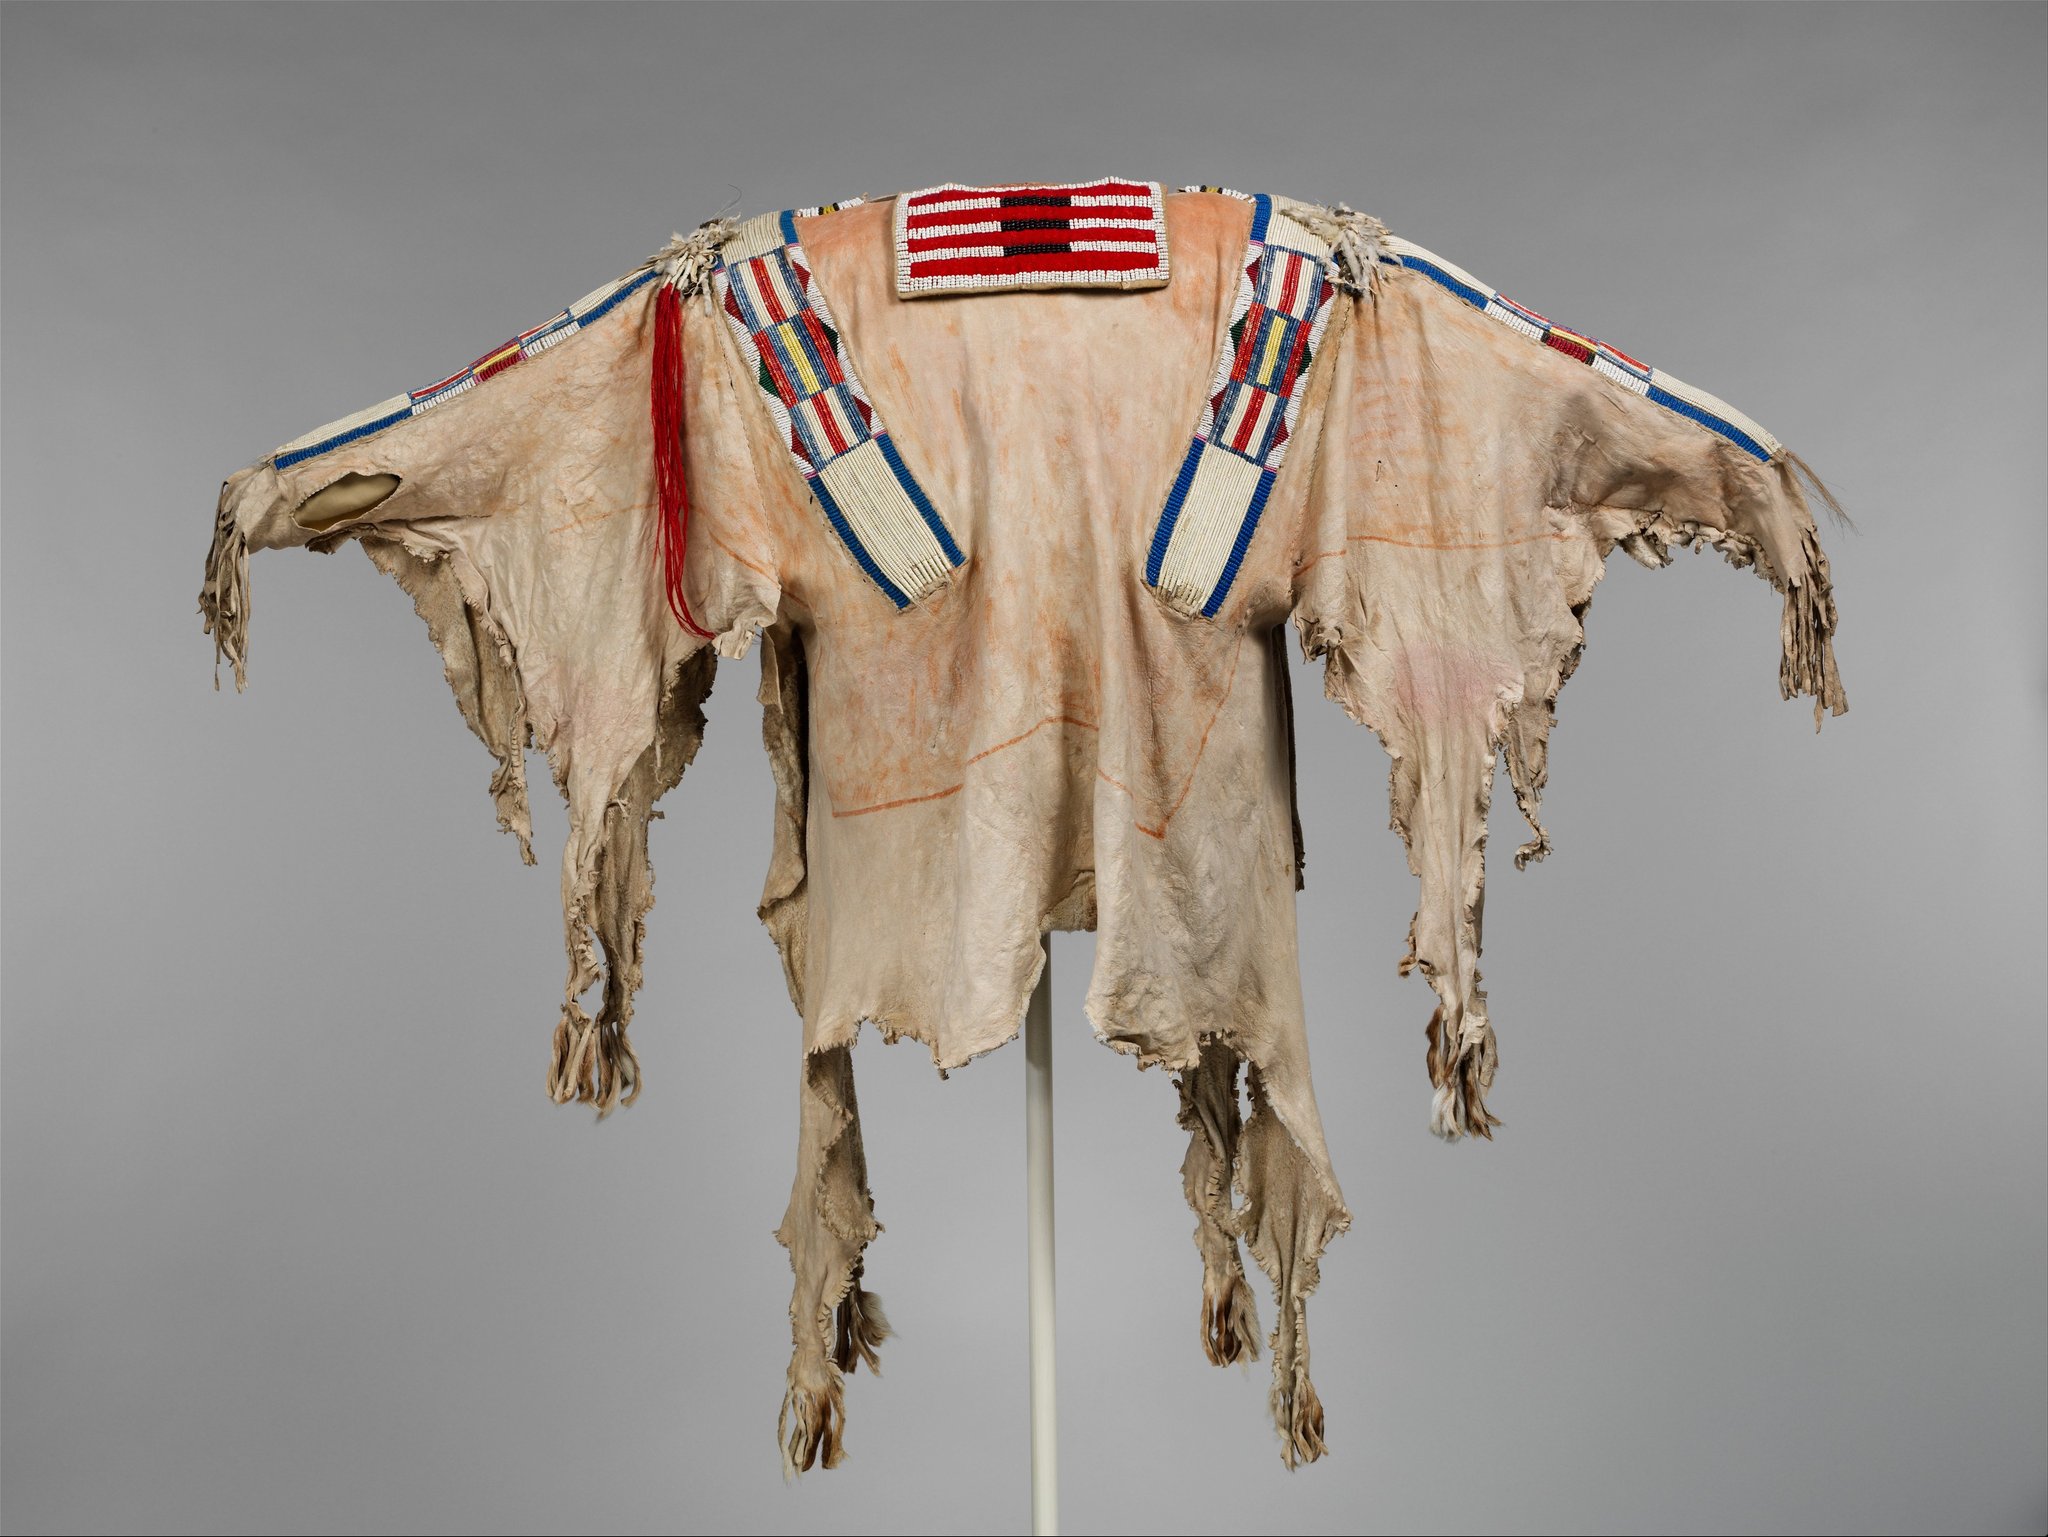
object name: shirt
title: Man's Shirt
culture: crow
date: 1860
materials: textile, glass, hair, skin, wool, thread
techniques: tanning, weave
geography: united states